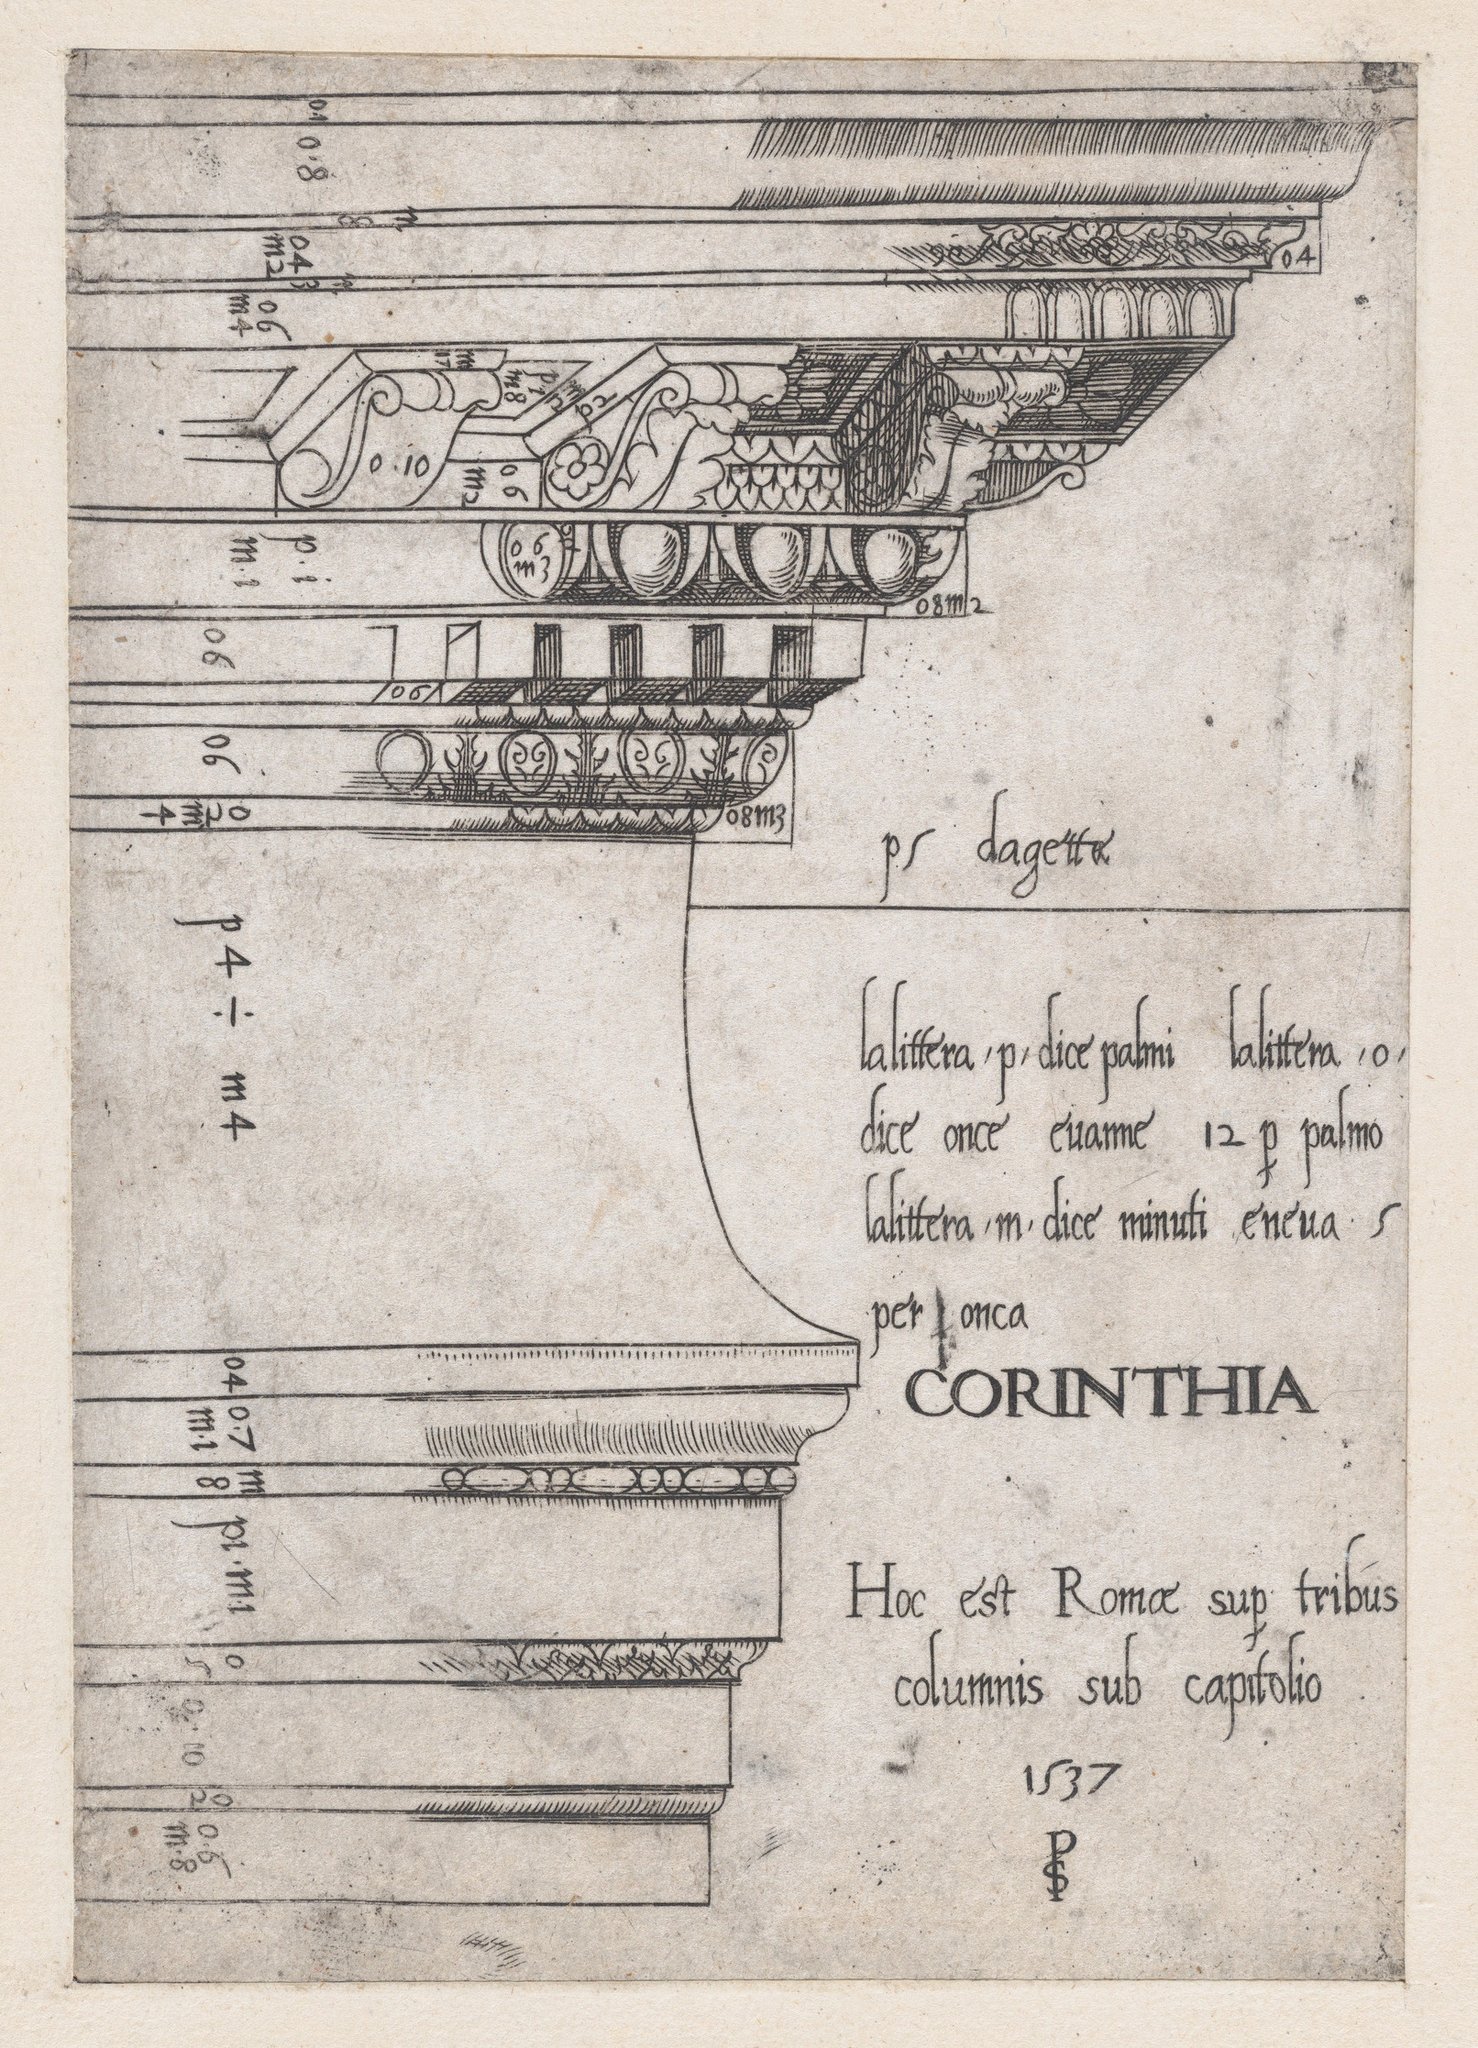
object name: print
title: Entablature from the Temple of Castor and Pollux, Rome, from "Speculum Romanae Magnificentiae"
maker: master ps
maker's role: artist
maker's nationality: italian or french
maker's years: 1530-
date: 1537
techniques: engraving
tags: architecture